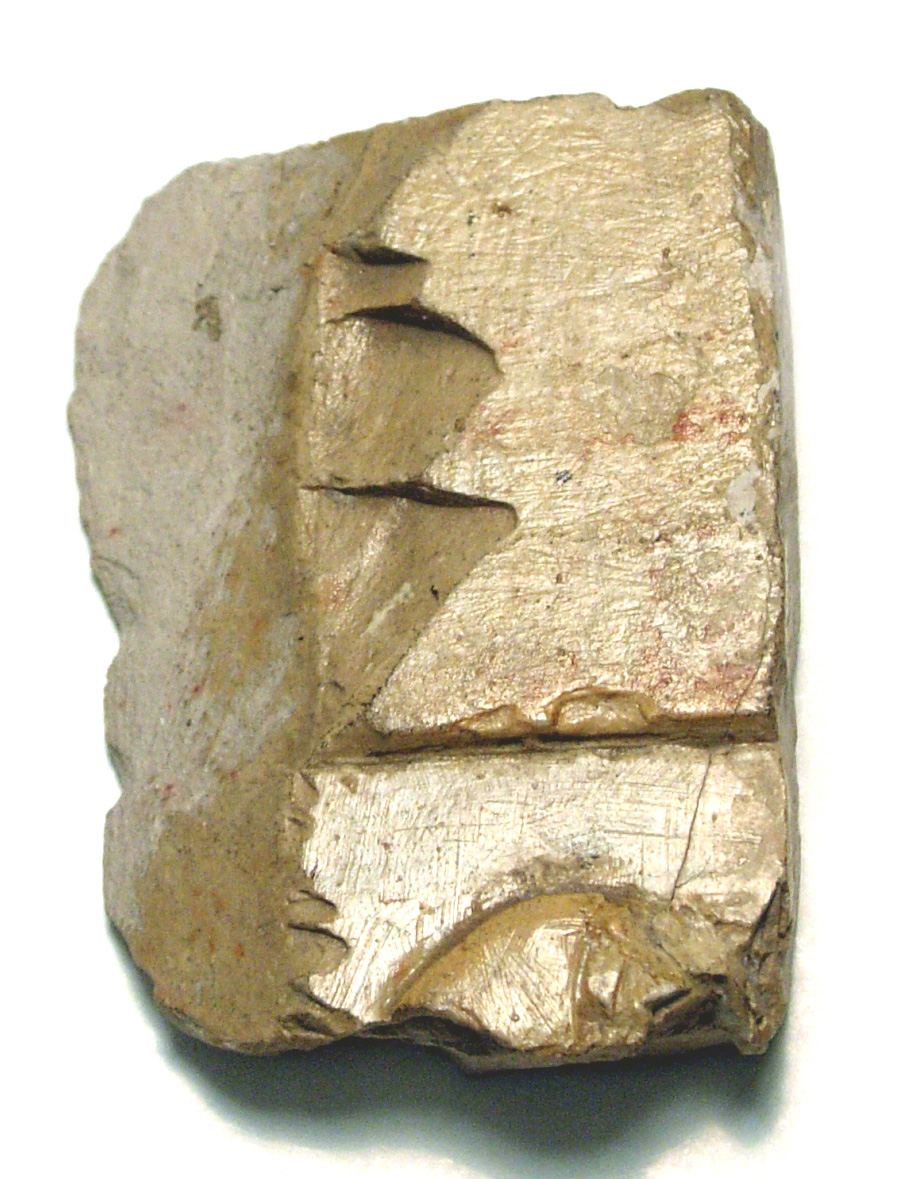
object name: relief, tomb of nespekashuty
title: Raised relief fragment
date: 664-610 BCE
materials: limestone, varnish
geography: egypt